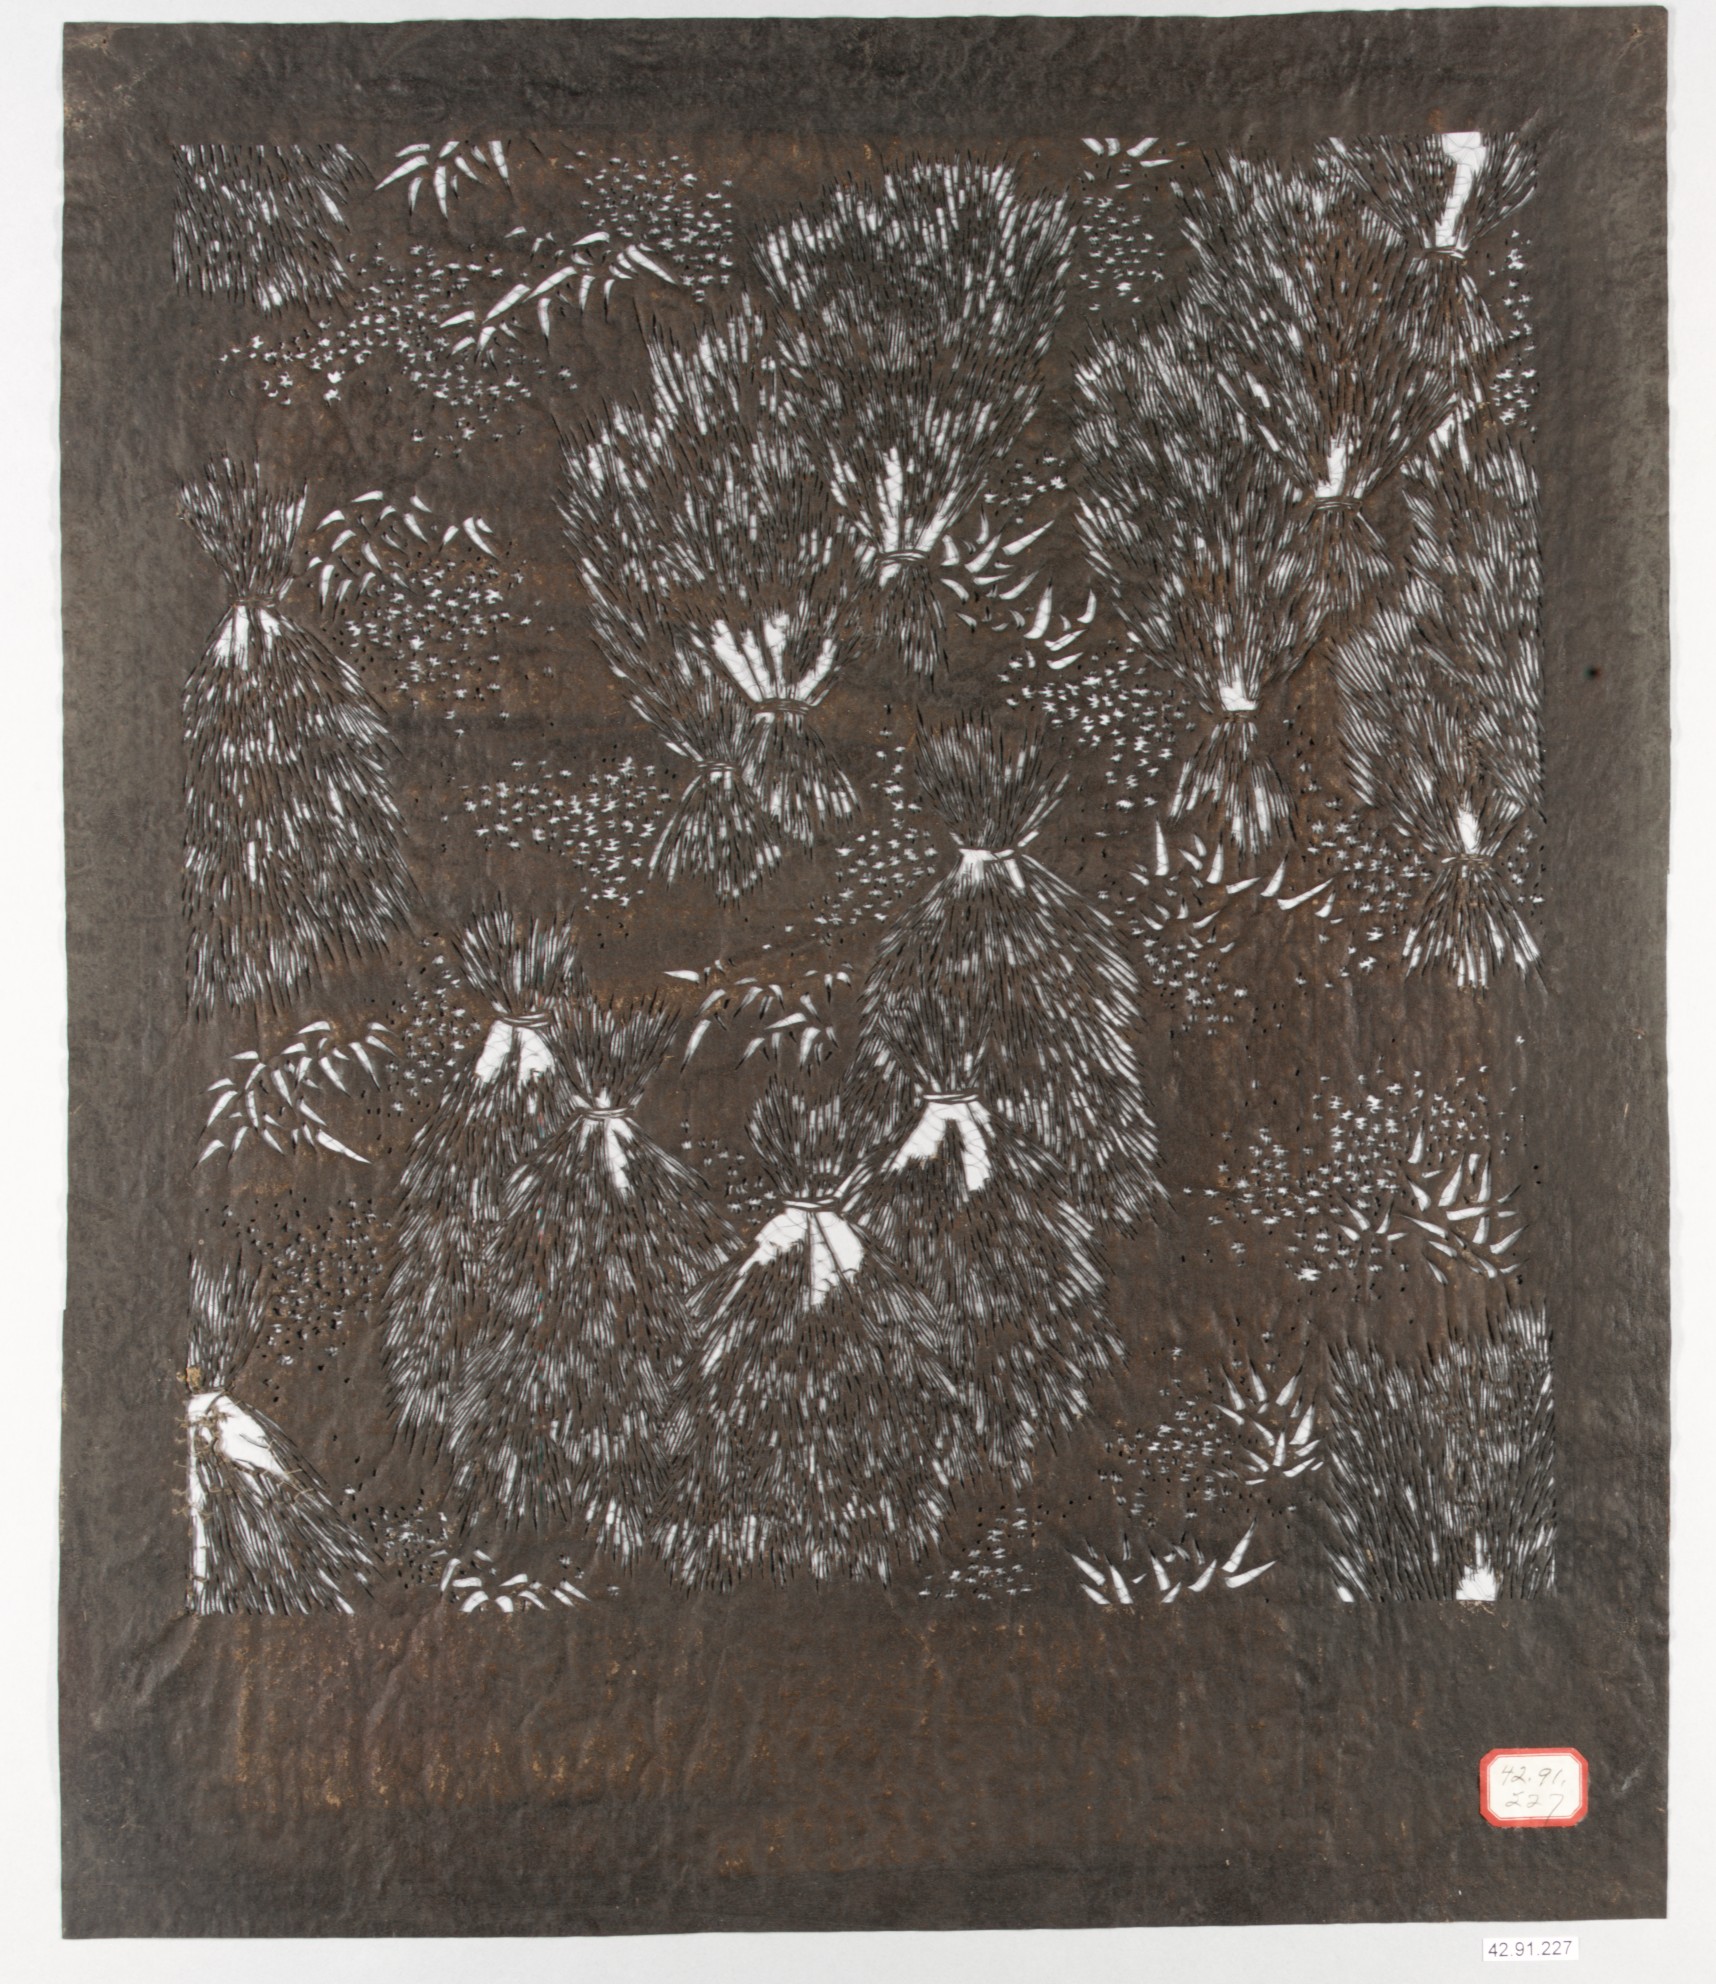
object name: stencil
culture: japanese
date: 1801-1900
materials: paper, silk